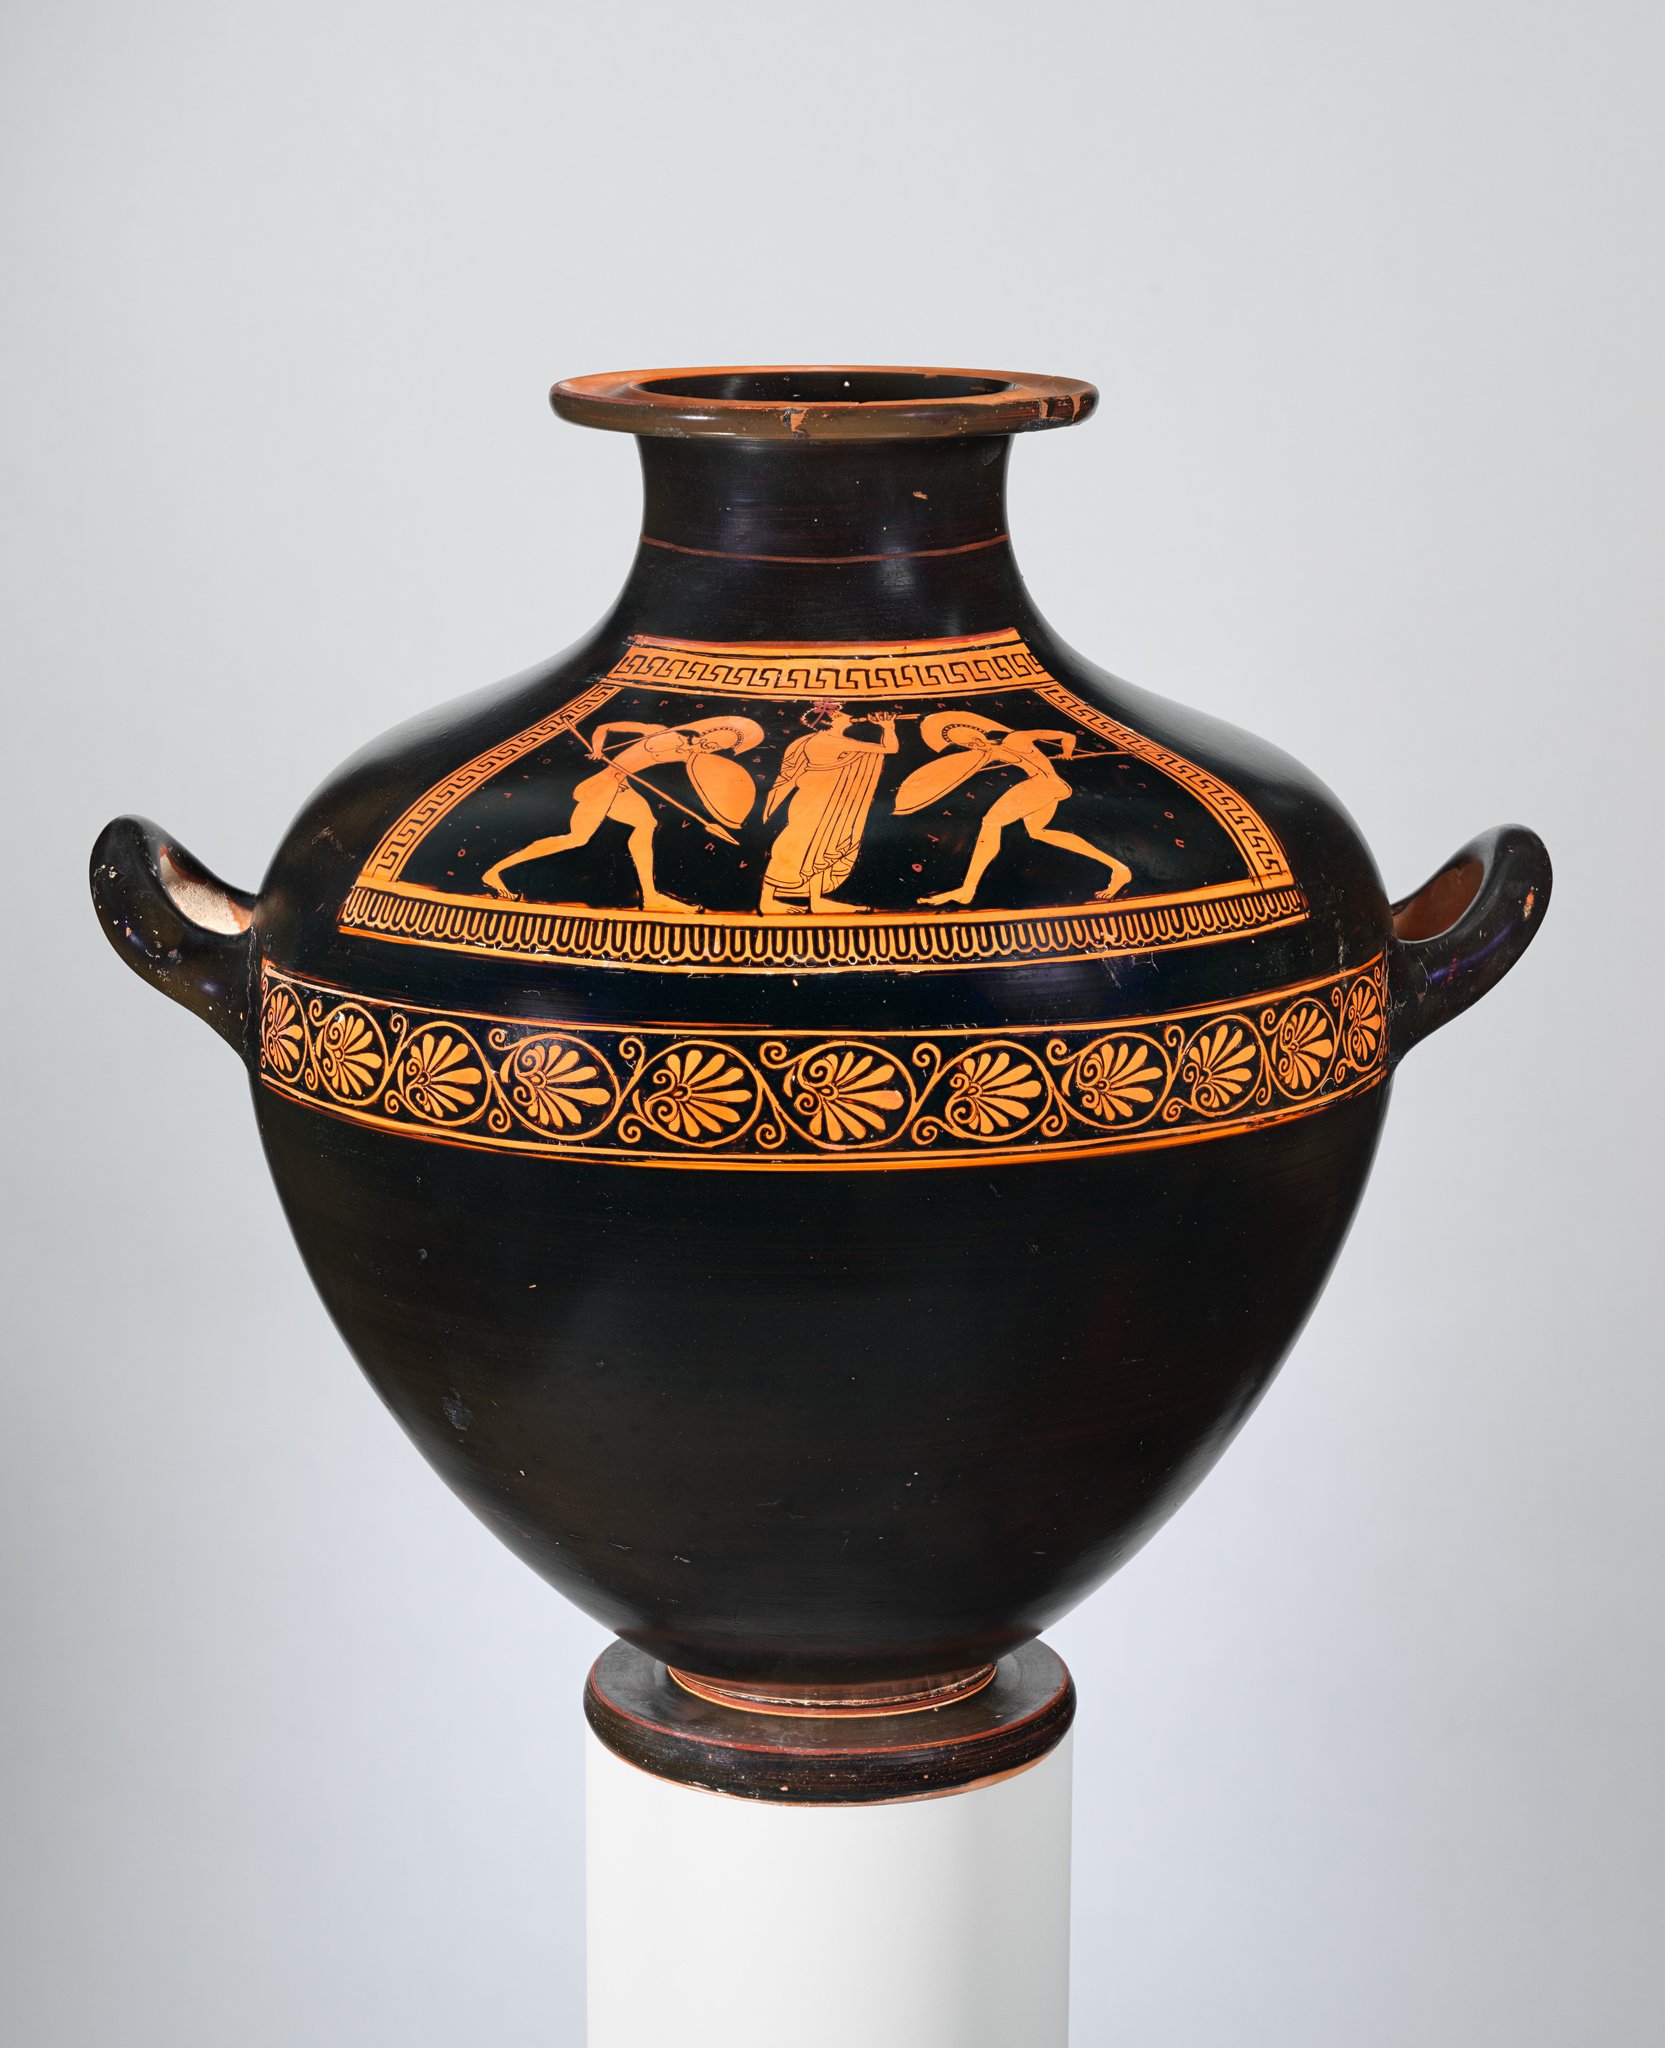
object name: hydria, kalpis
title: Terracotta hydria: kalpis (water jar)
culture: greek, attic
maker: dikaios painter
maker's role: artist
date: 500 BCE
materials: terracotta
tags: shields,spears,men,flutes,musicians